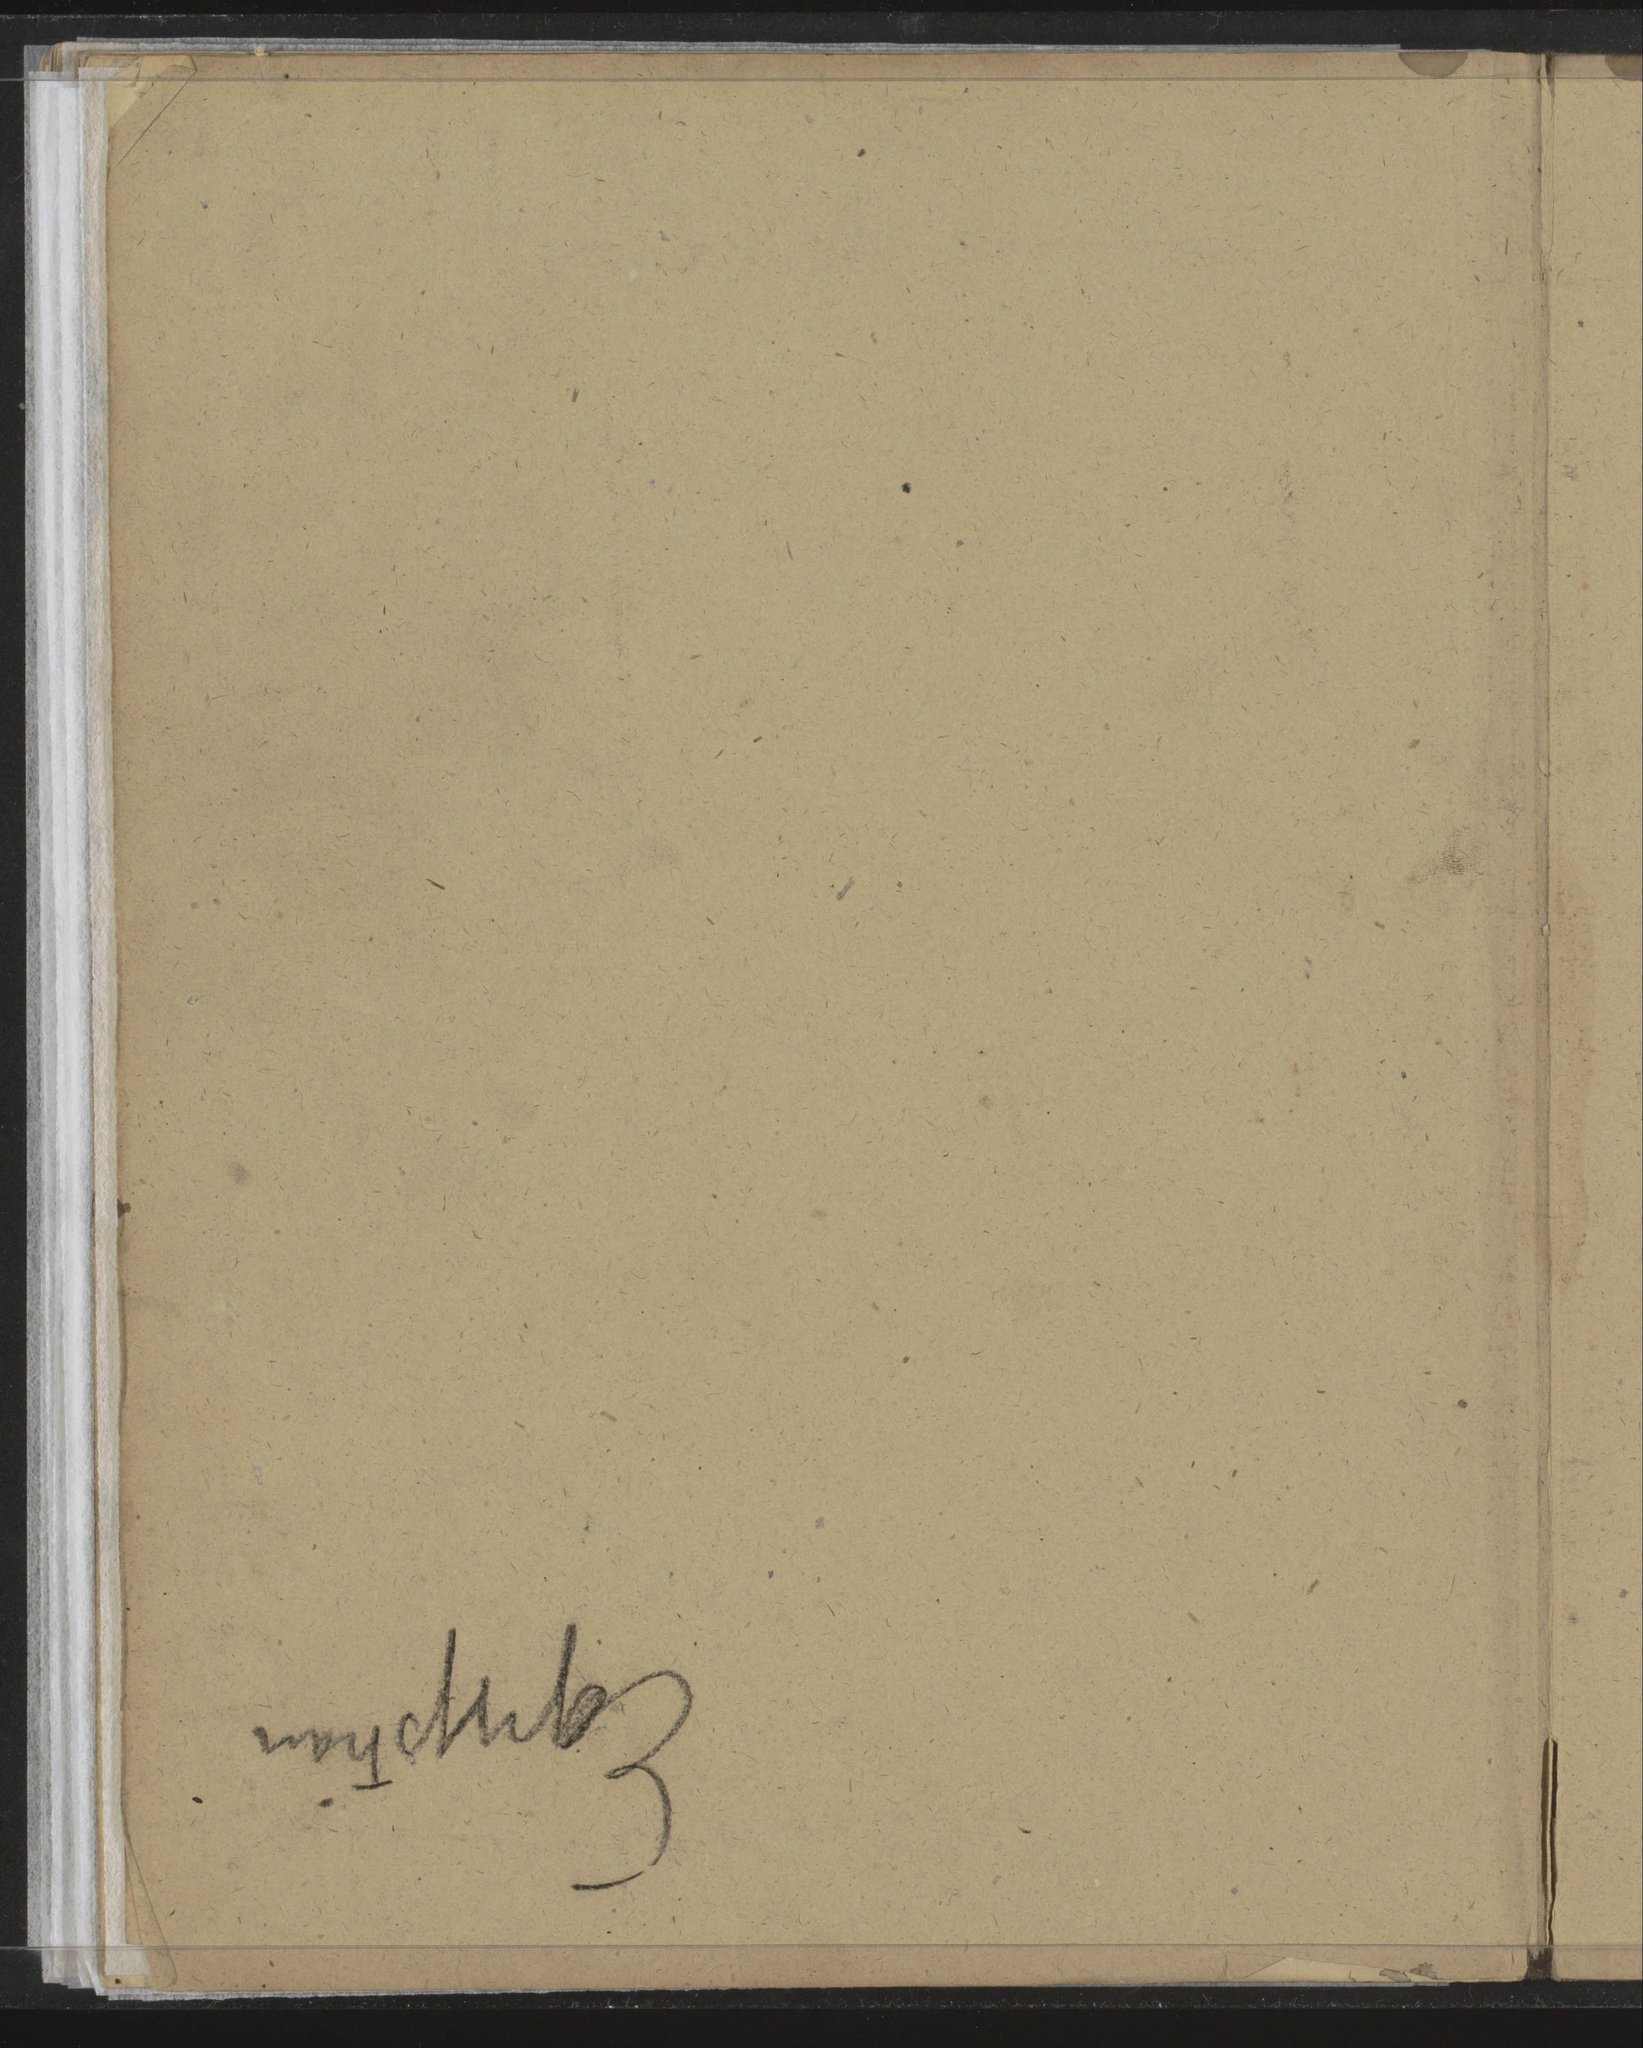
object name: endleaf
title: Annotatie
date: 1887-1888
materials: chalk, paper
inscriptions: annotation: ‘Egyptian’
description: Pagina 88, vrij schutblad, uit een schetsboek met 43 bladen.